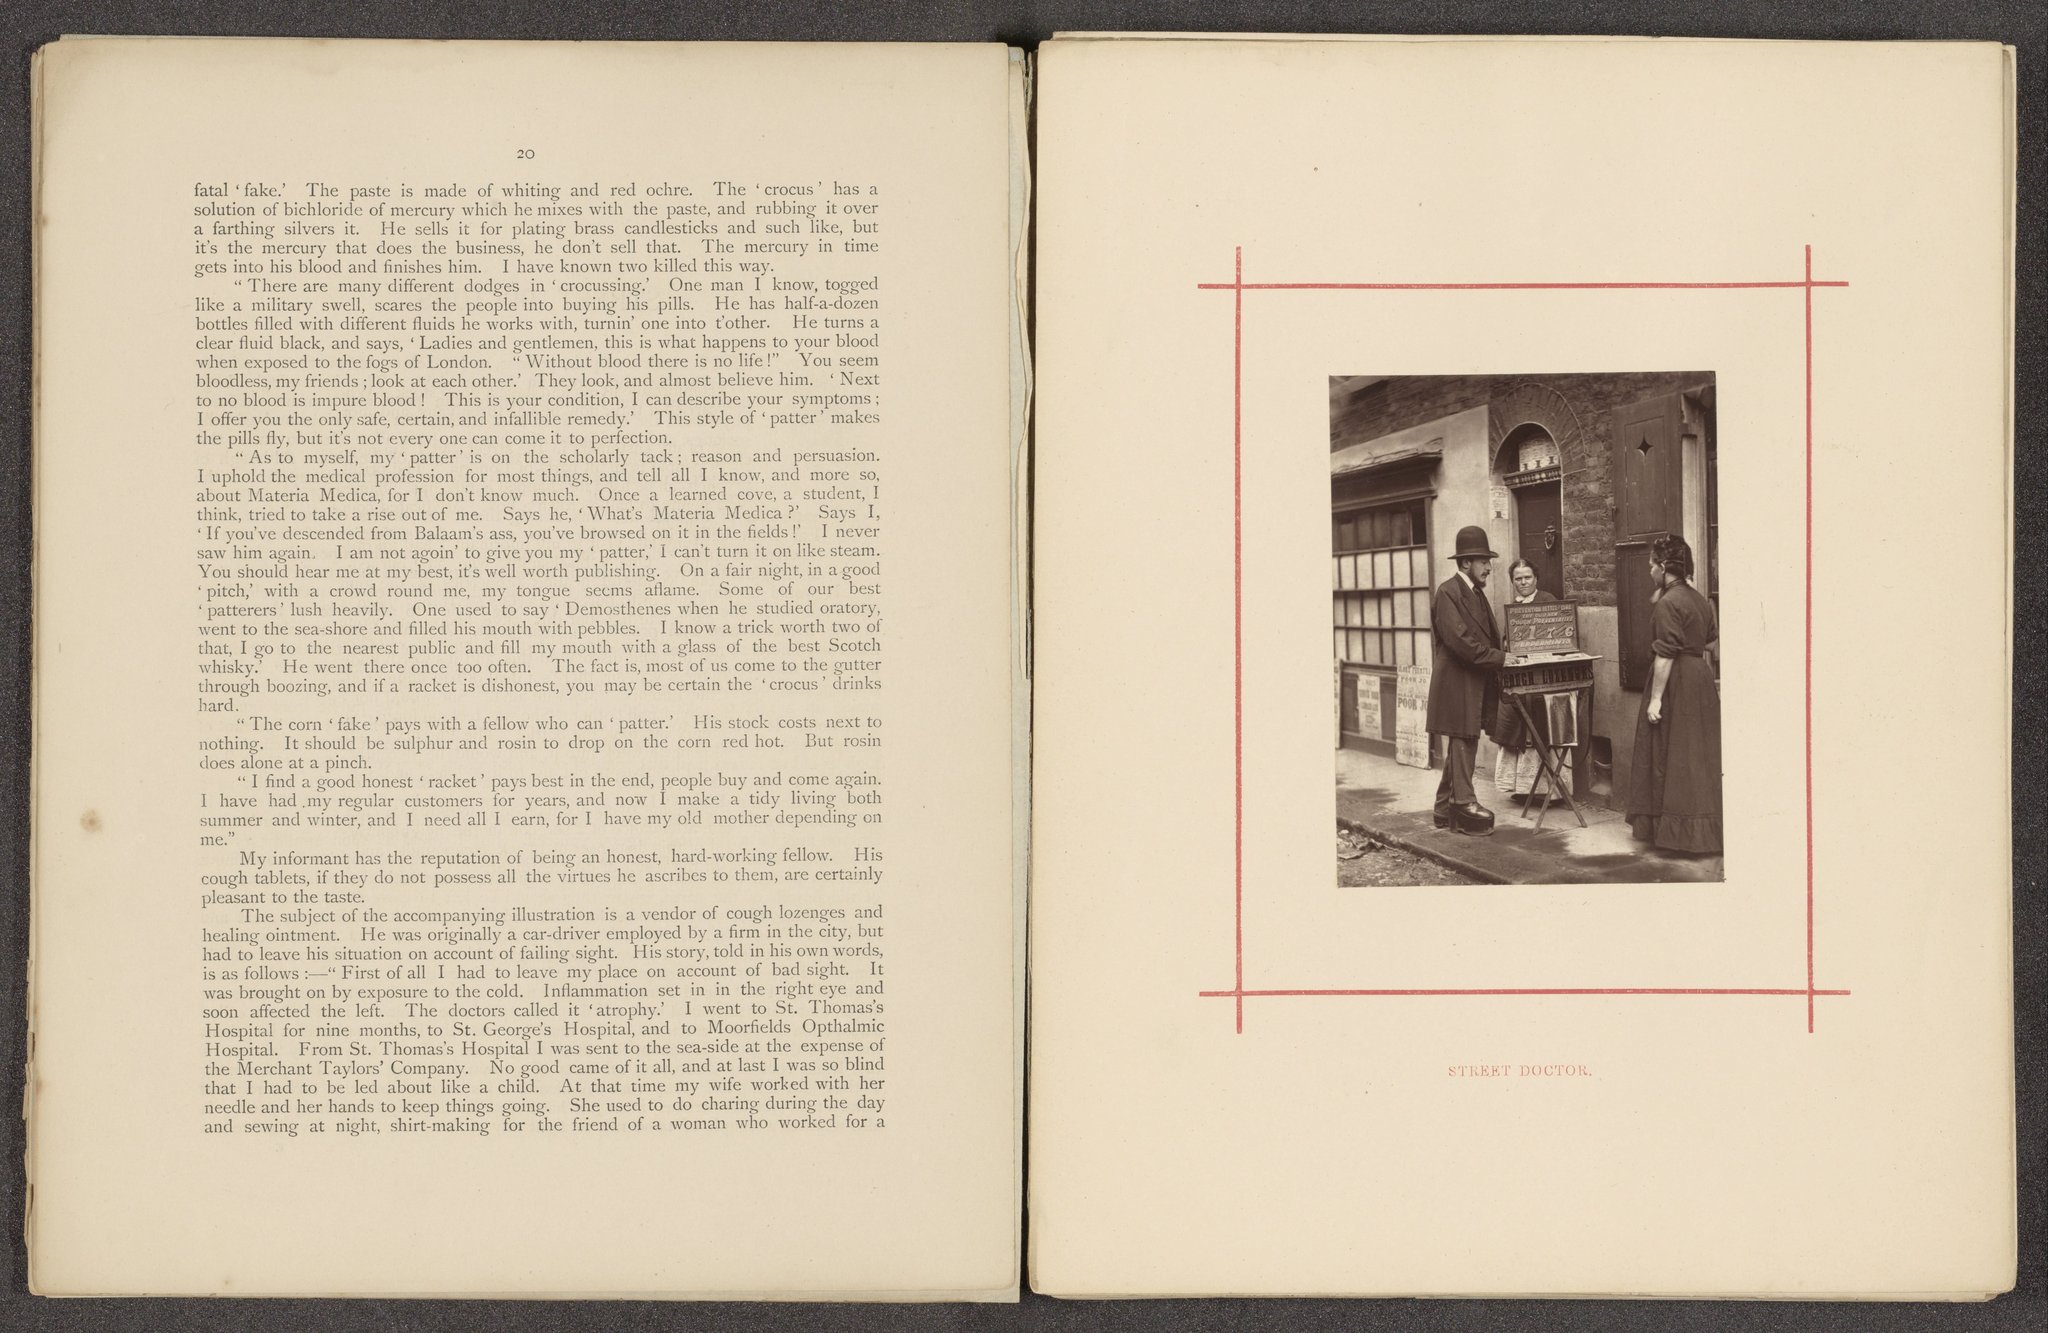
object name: photomechanical print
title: Street Doctor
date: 1876-1877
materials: paper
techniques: woodburytype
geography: london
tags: physician, doctor, street-trader, london